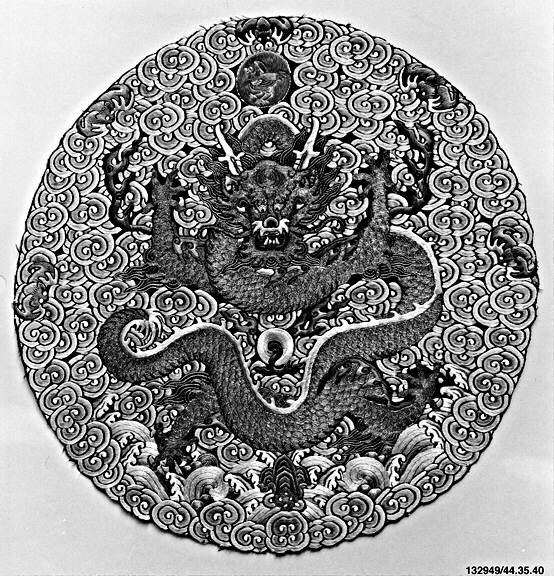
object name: medallion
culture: chinese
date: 1767-1833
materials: metal thread, silk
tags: dragons